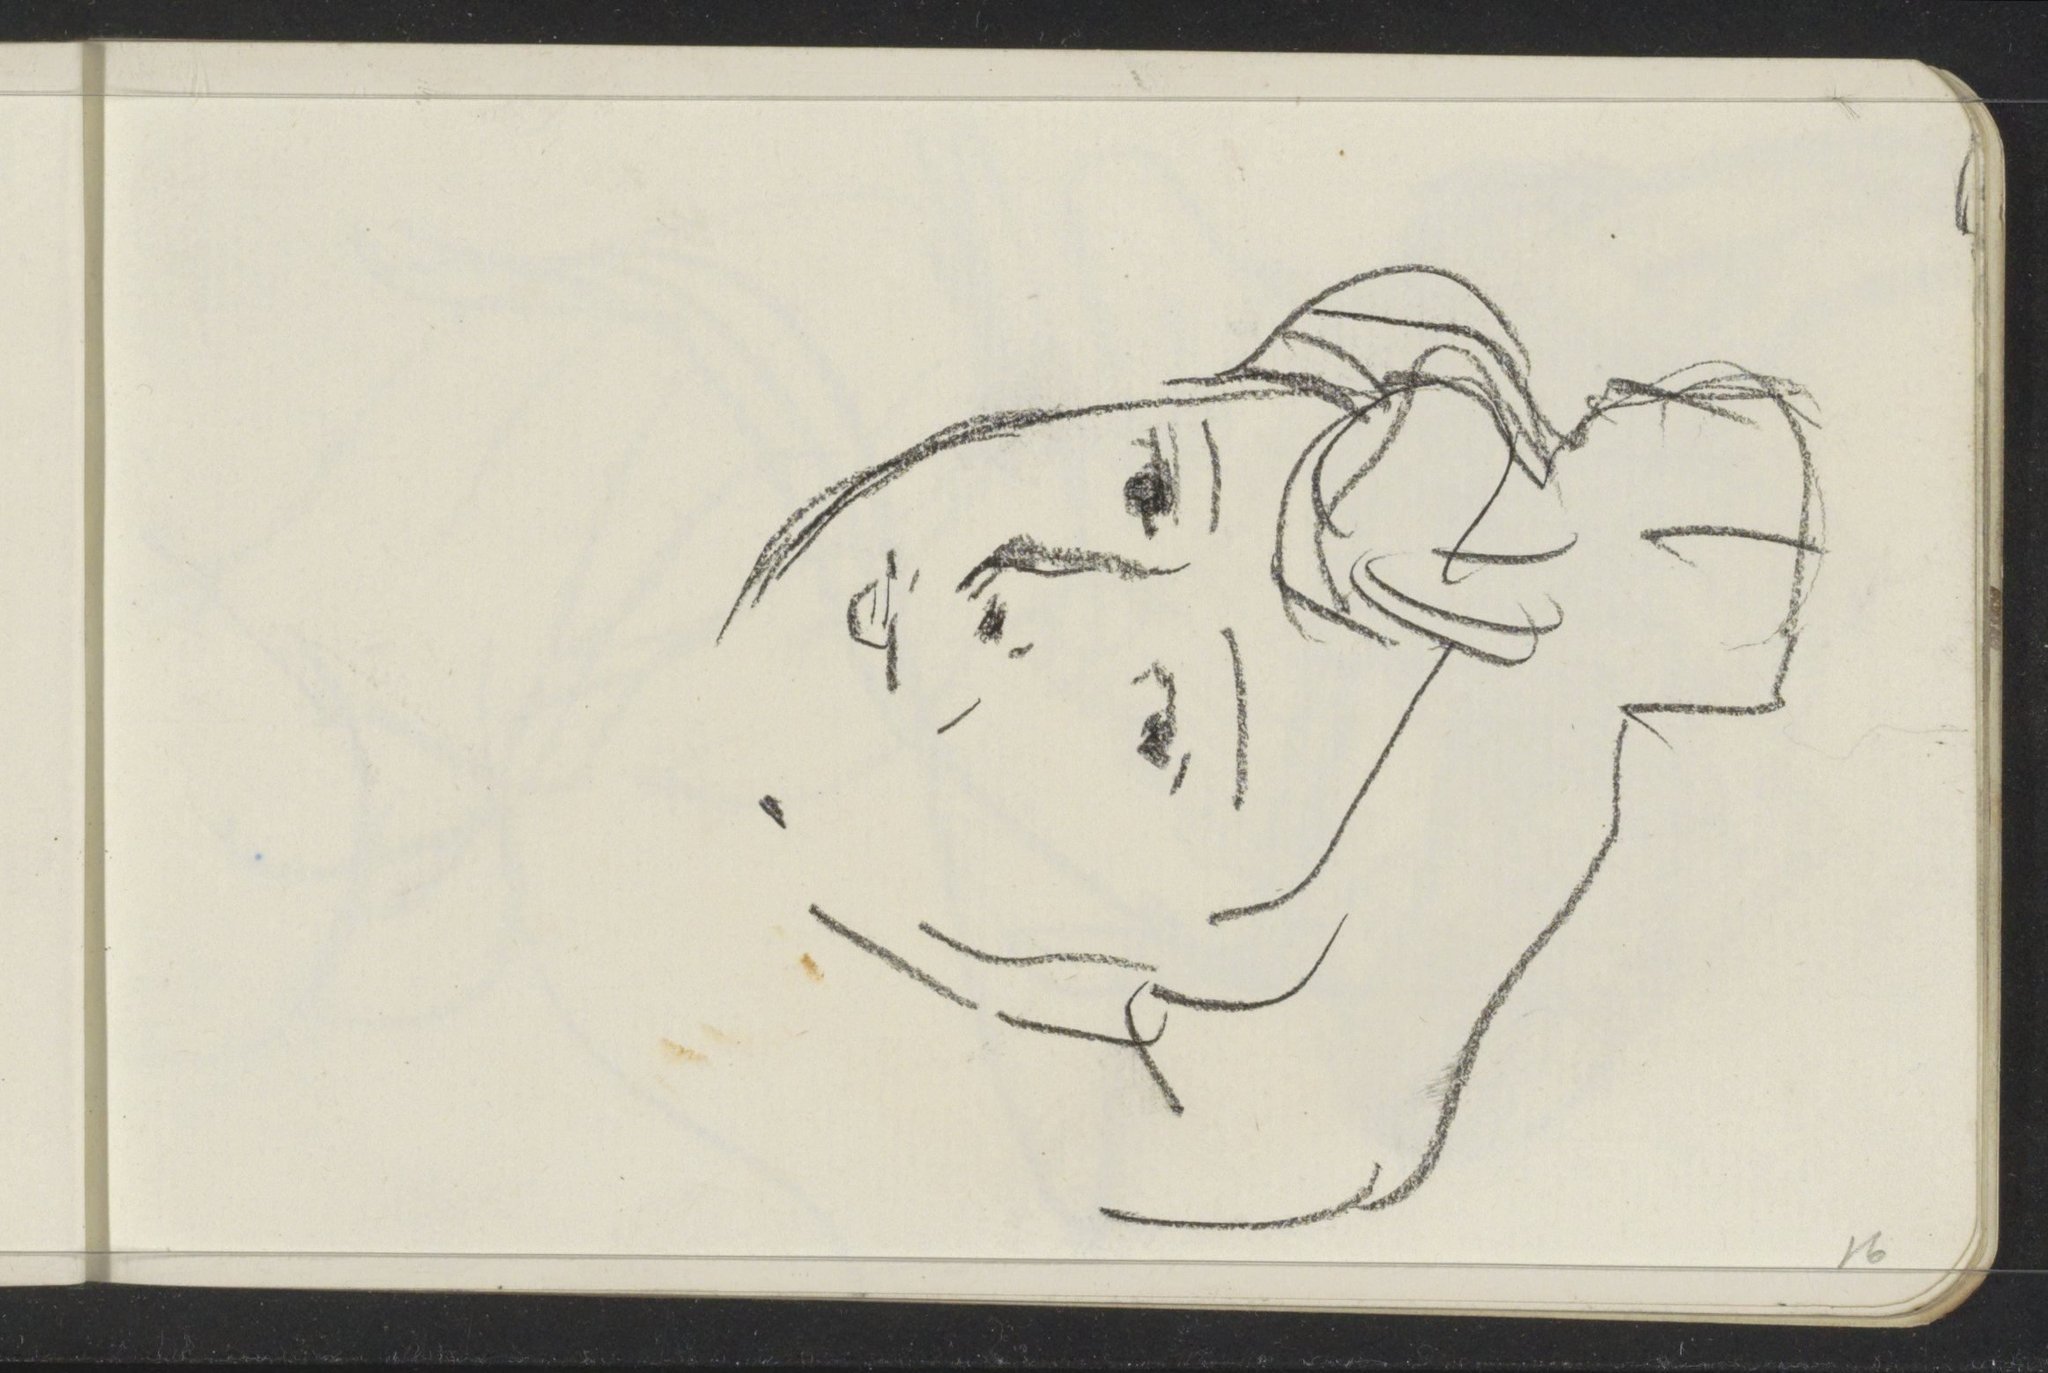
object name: sketchbook leaf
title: Vrouwenhoofd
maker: isaac israels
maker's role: draughtsman, painter, print maker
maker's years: 1865-1934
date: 1875-1934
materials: chalk, paper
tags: head (human) - aa - female human figure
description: Blad 16 recto uit schetsboek LXII met 28 bladen.